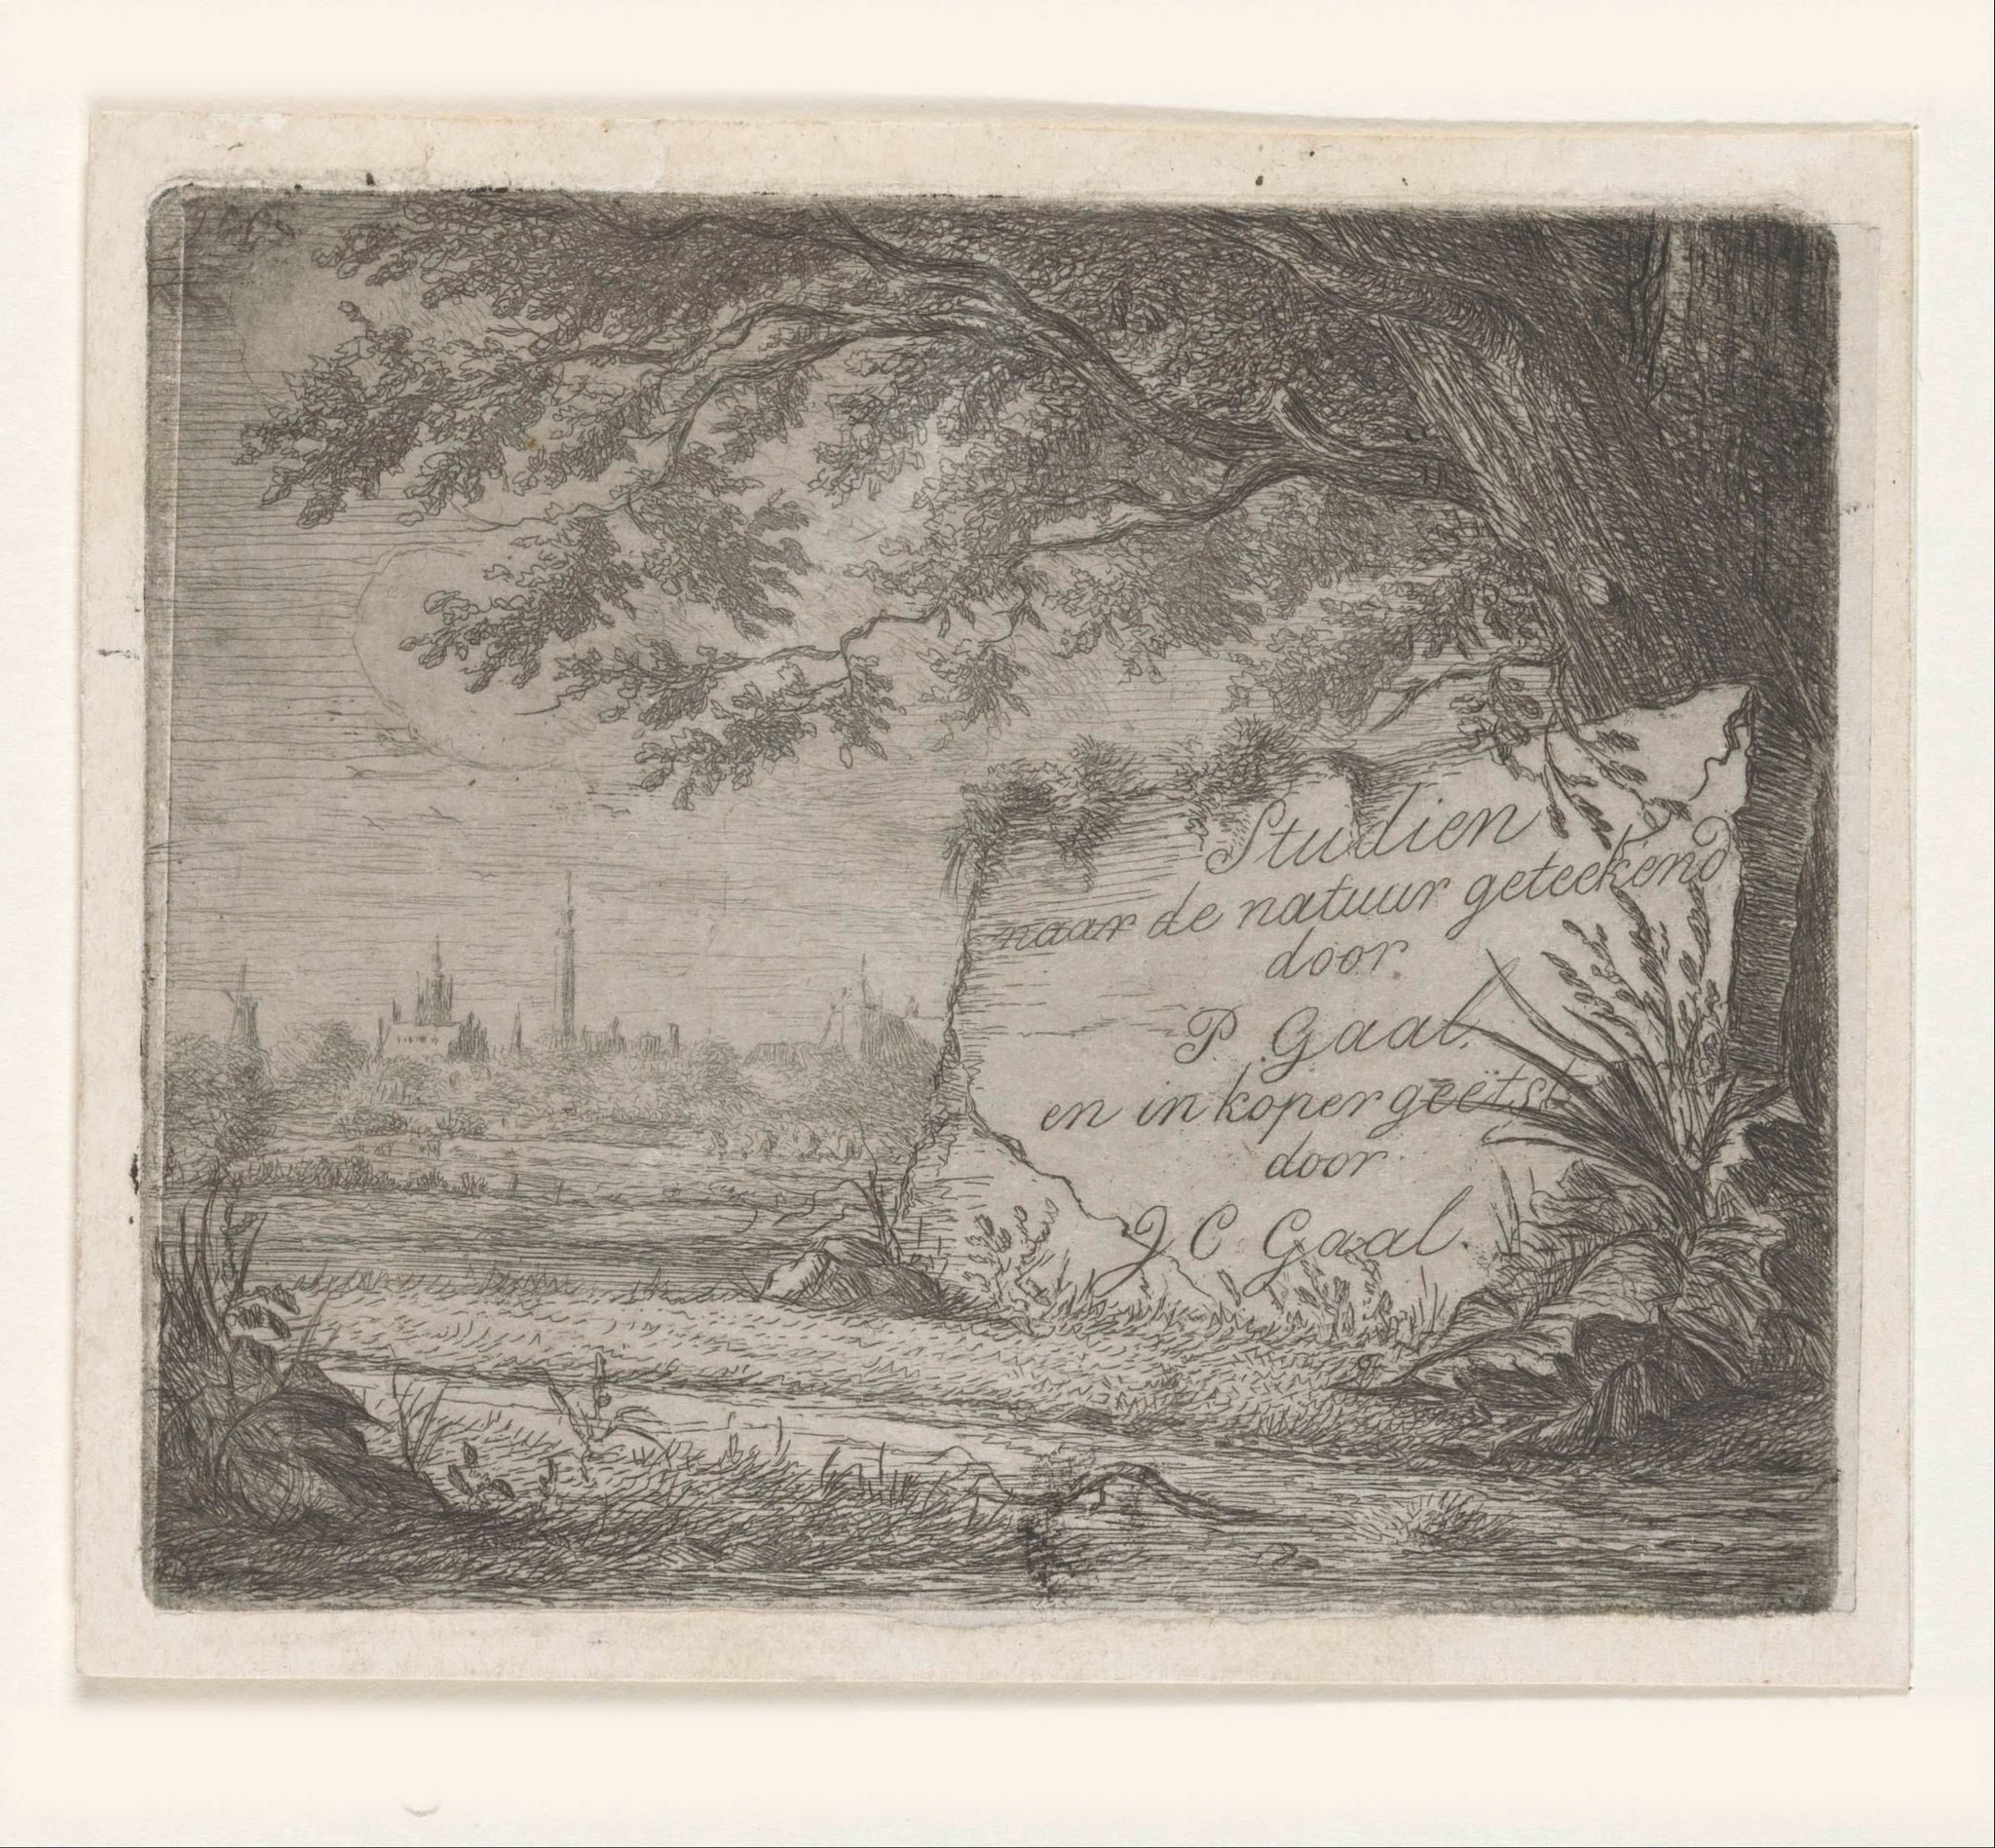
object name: titelprent, frontispice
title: Studien naar de natuur geteekend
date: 1846-1856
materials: paper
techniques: etching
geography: the hague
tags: landscapes in the temperate zone, the hague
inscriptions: collector's mark: Lugt 2760, collector's mark: Lugt 2228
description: Landschap met in het verschiet een stad, mogelijk Den Haag. Onder een boom een steen met de titel.